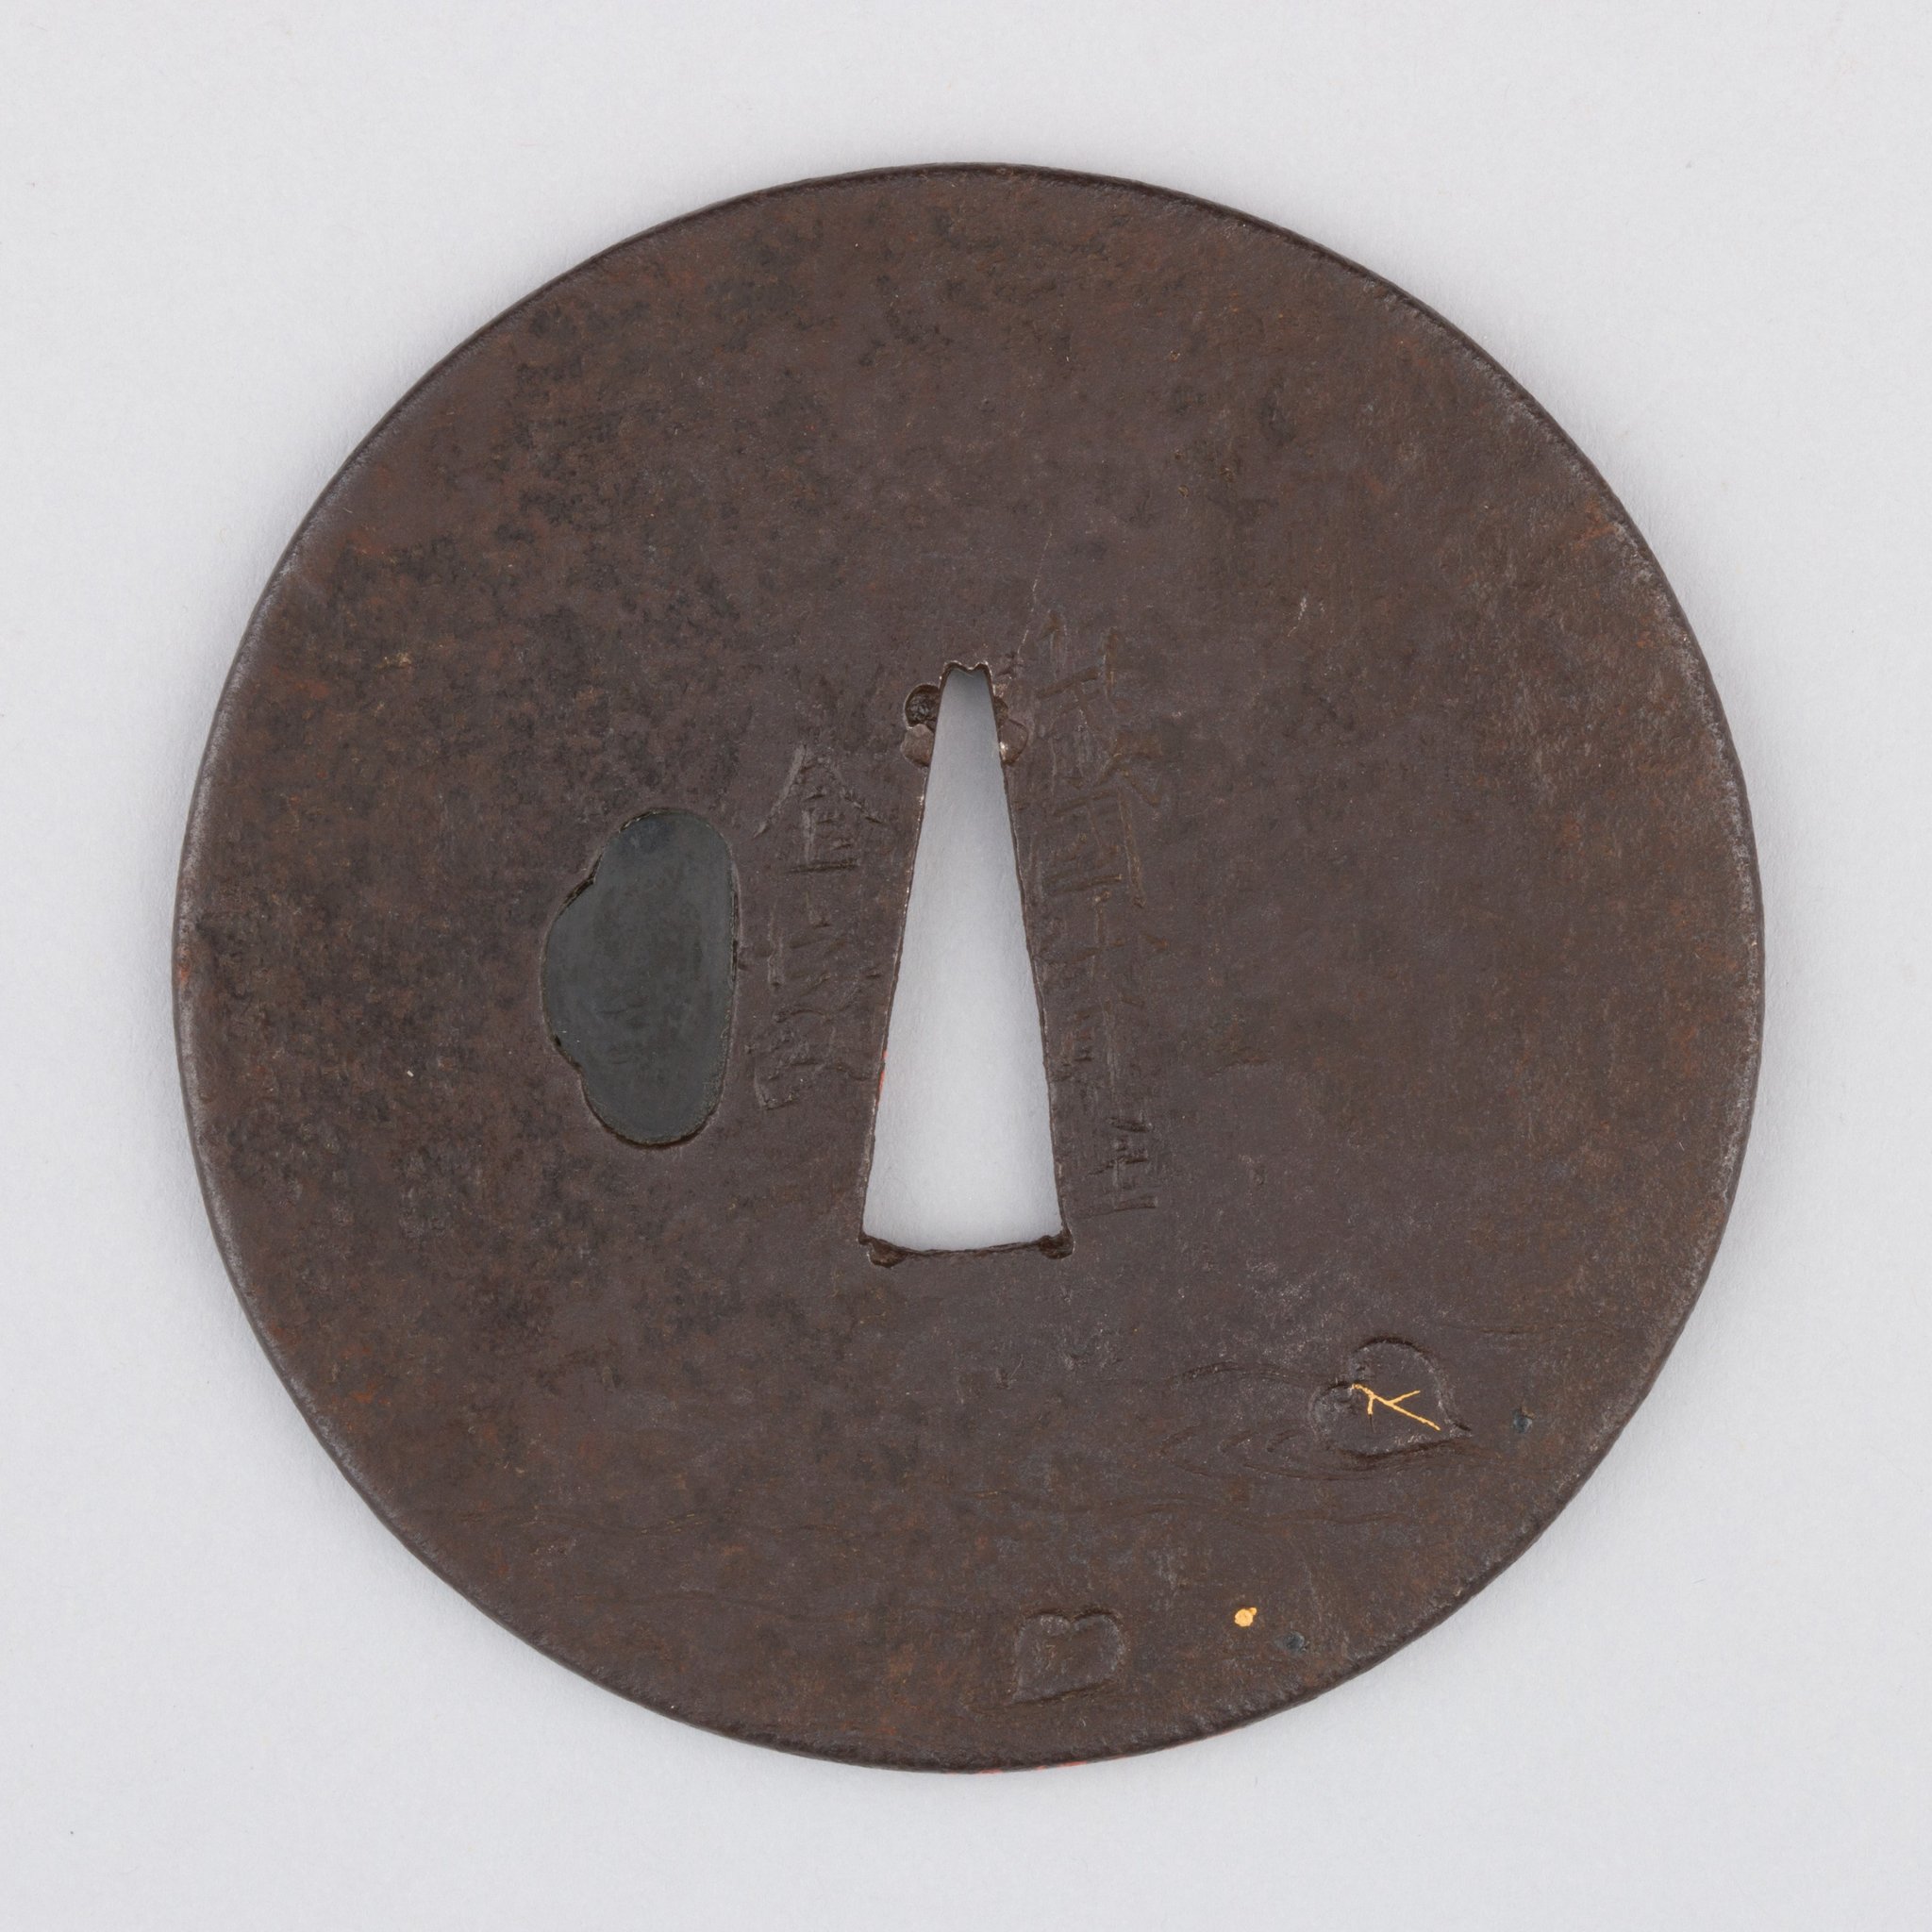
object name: sword guard tsuba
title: Sword Guard (Tsuba)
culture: japanese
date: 1615-1868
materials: copper, iron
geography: japan